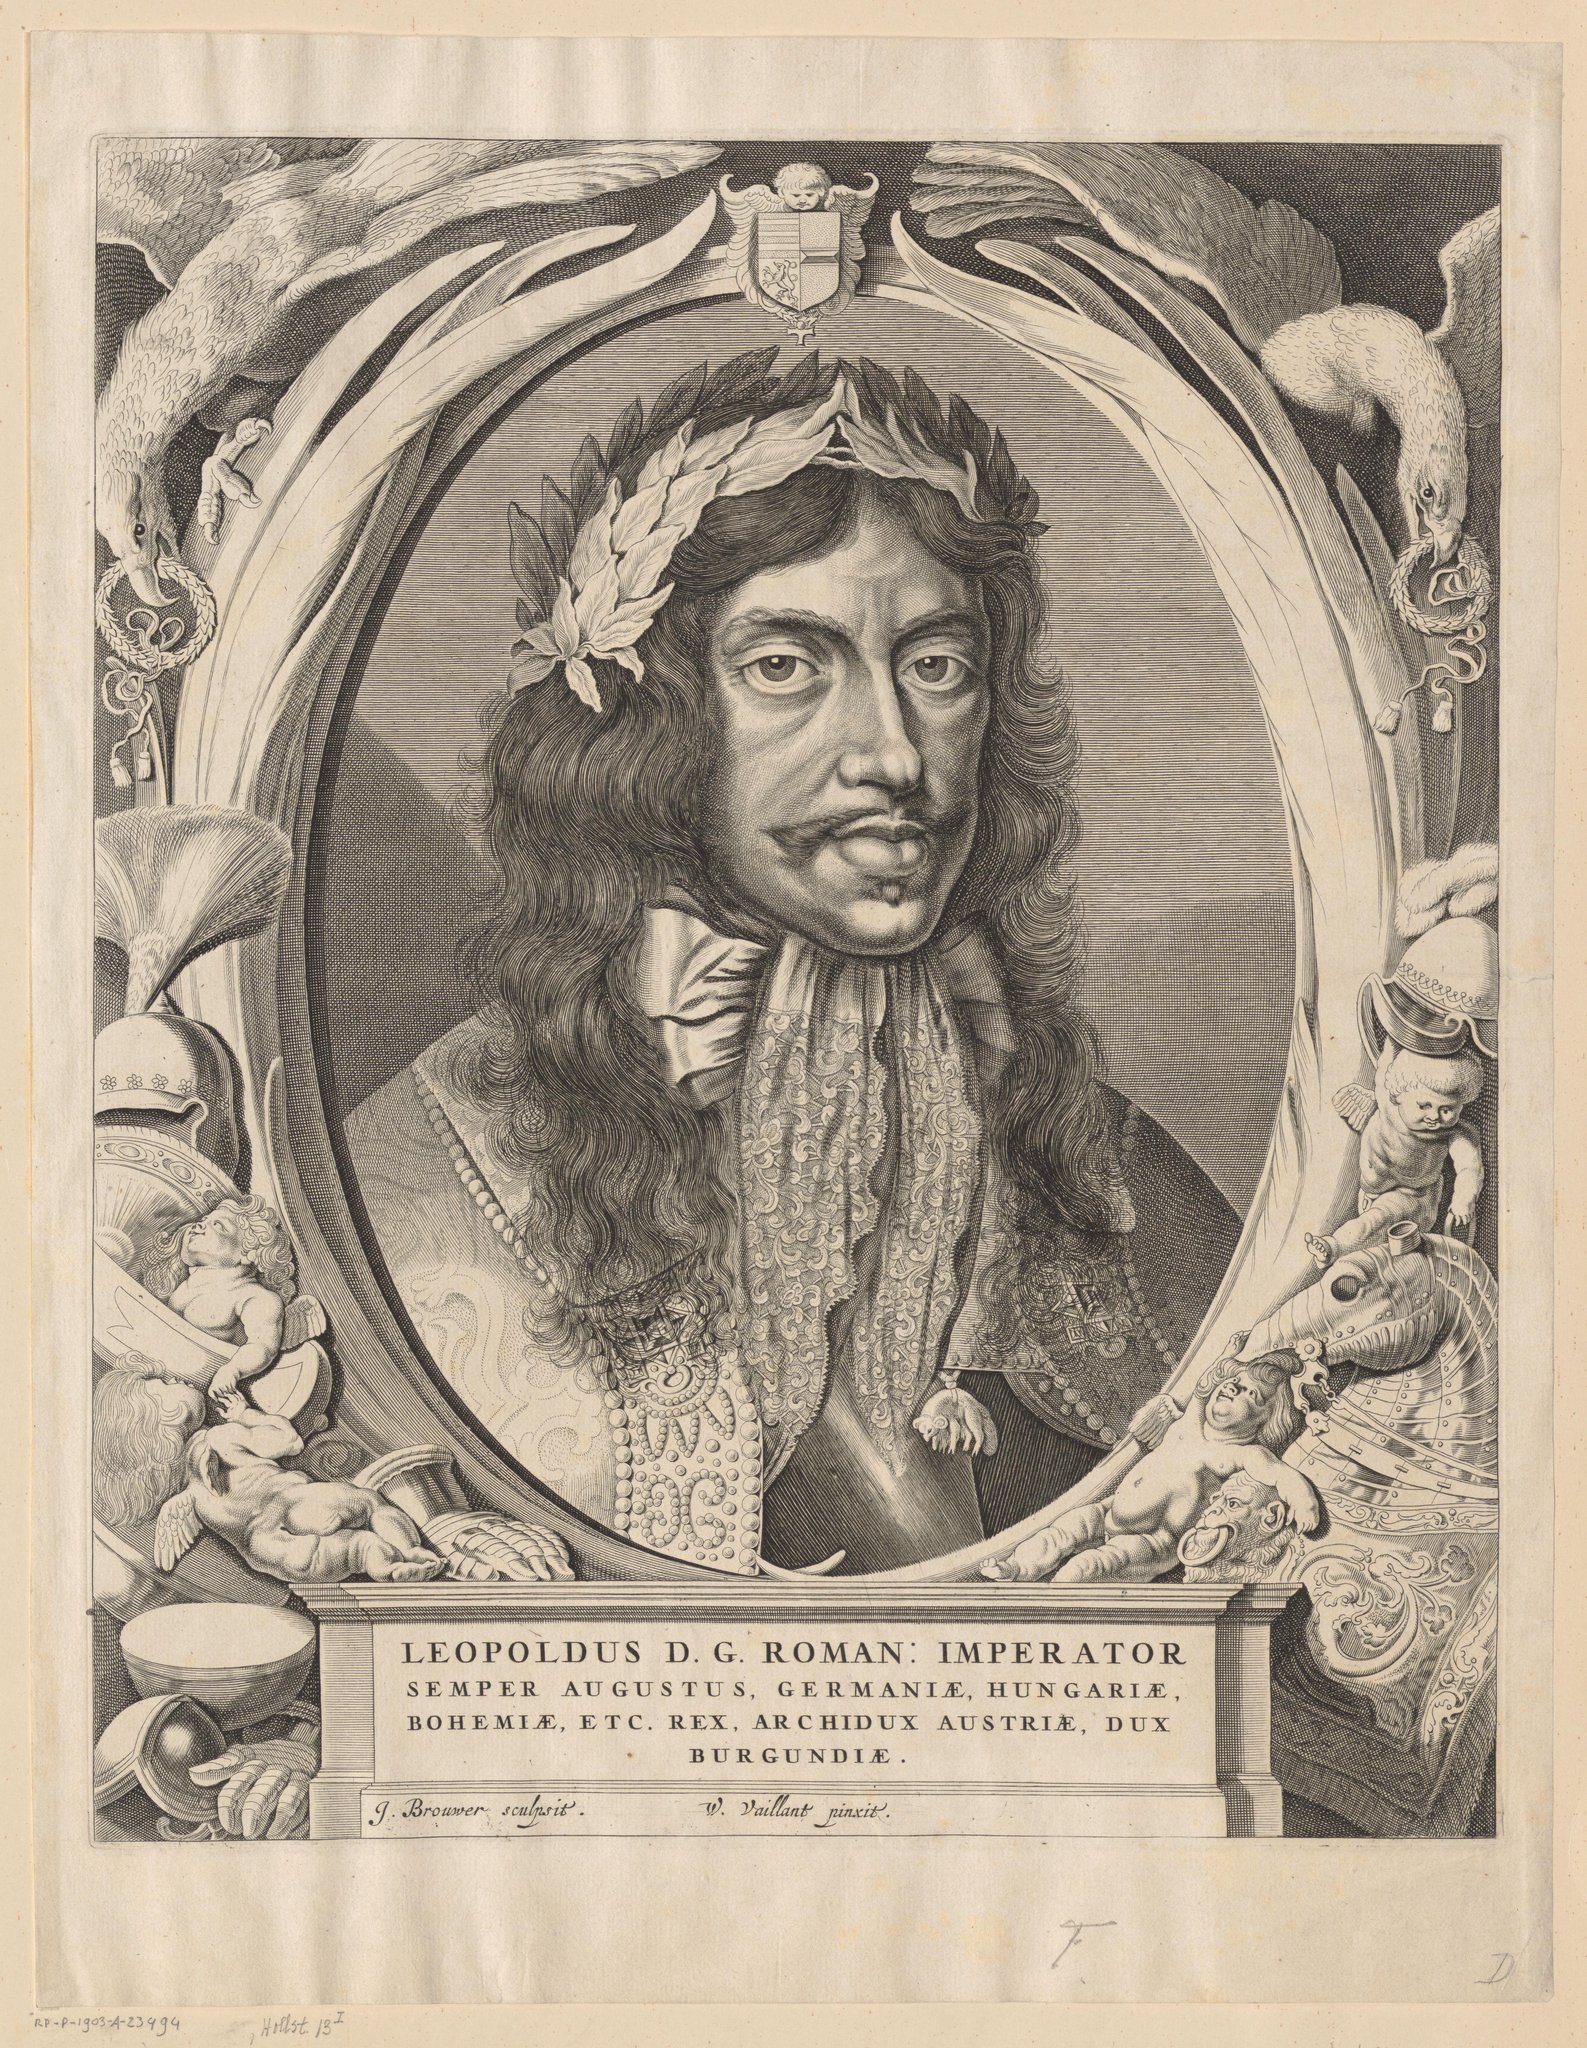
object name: print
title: Portret van keizer Leopold I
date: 1658-1688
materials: paper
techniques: engraving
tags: vienna, leopold i (keizer van duitsland), historical persons, emperor, crowning with laurel, cupids: 'amores', 'amoretti', 'putti'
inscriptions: collector's mark: Lugt 2228